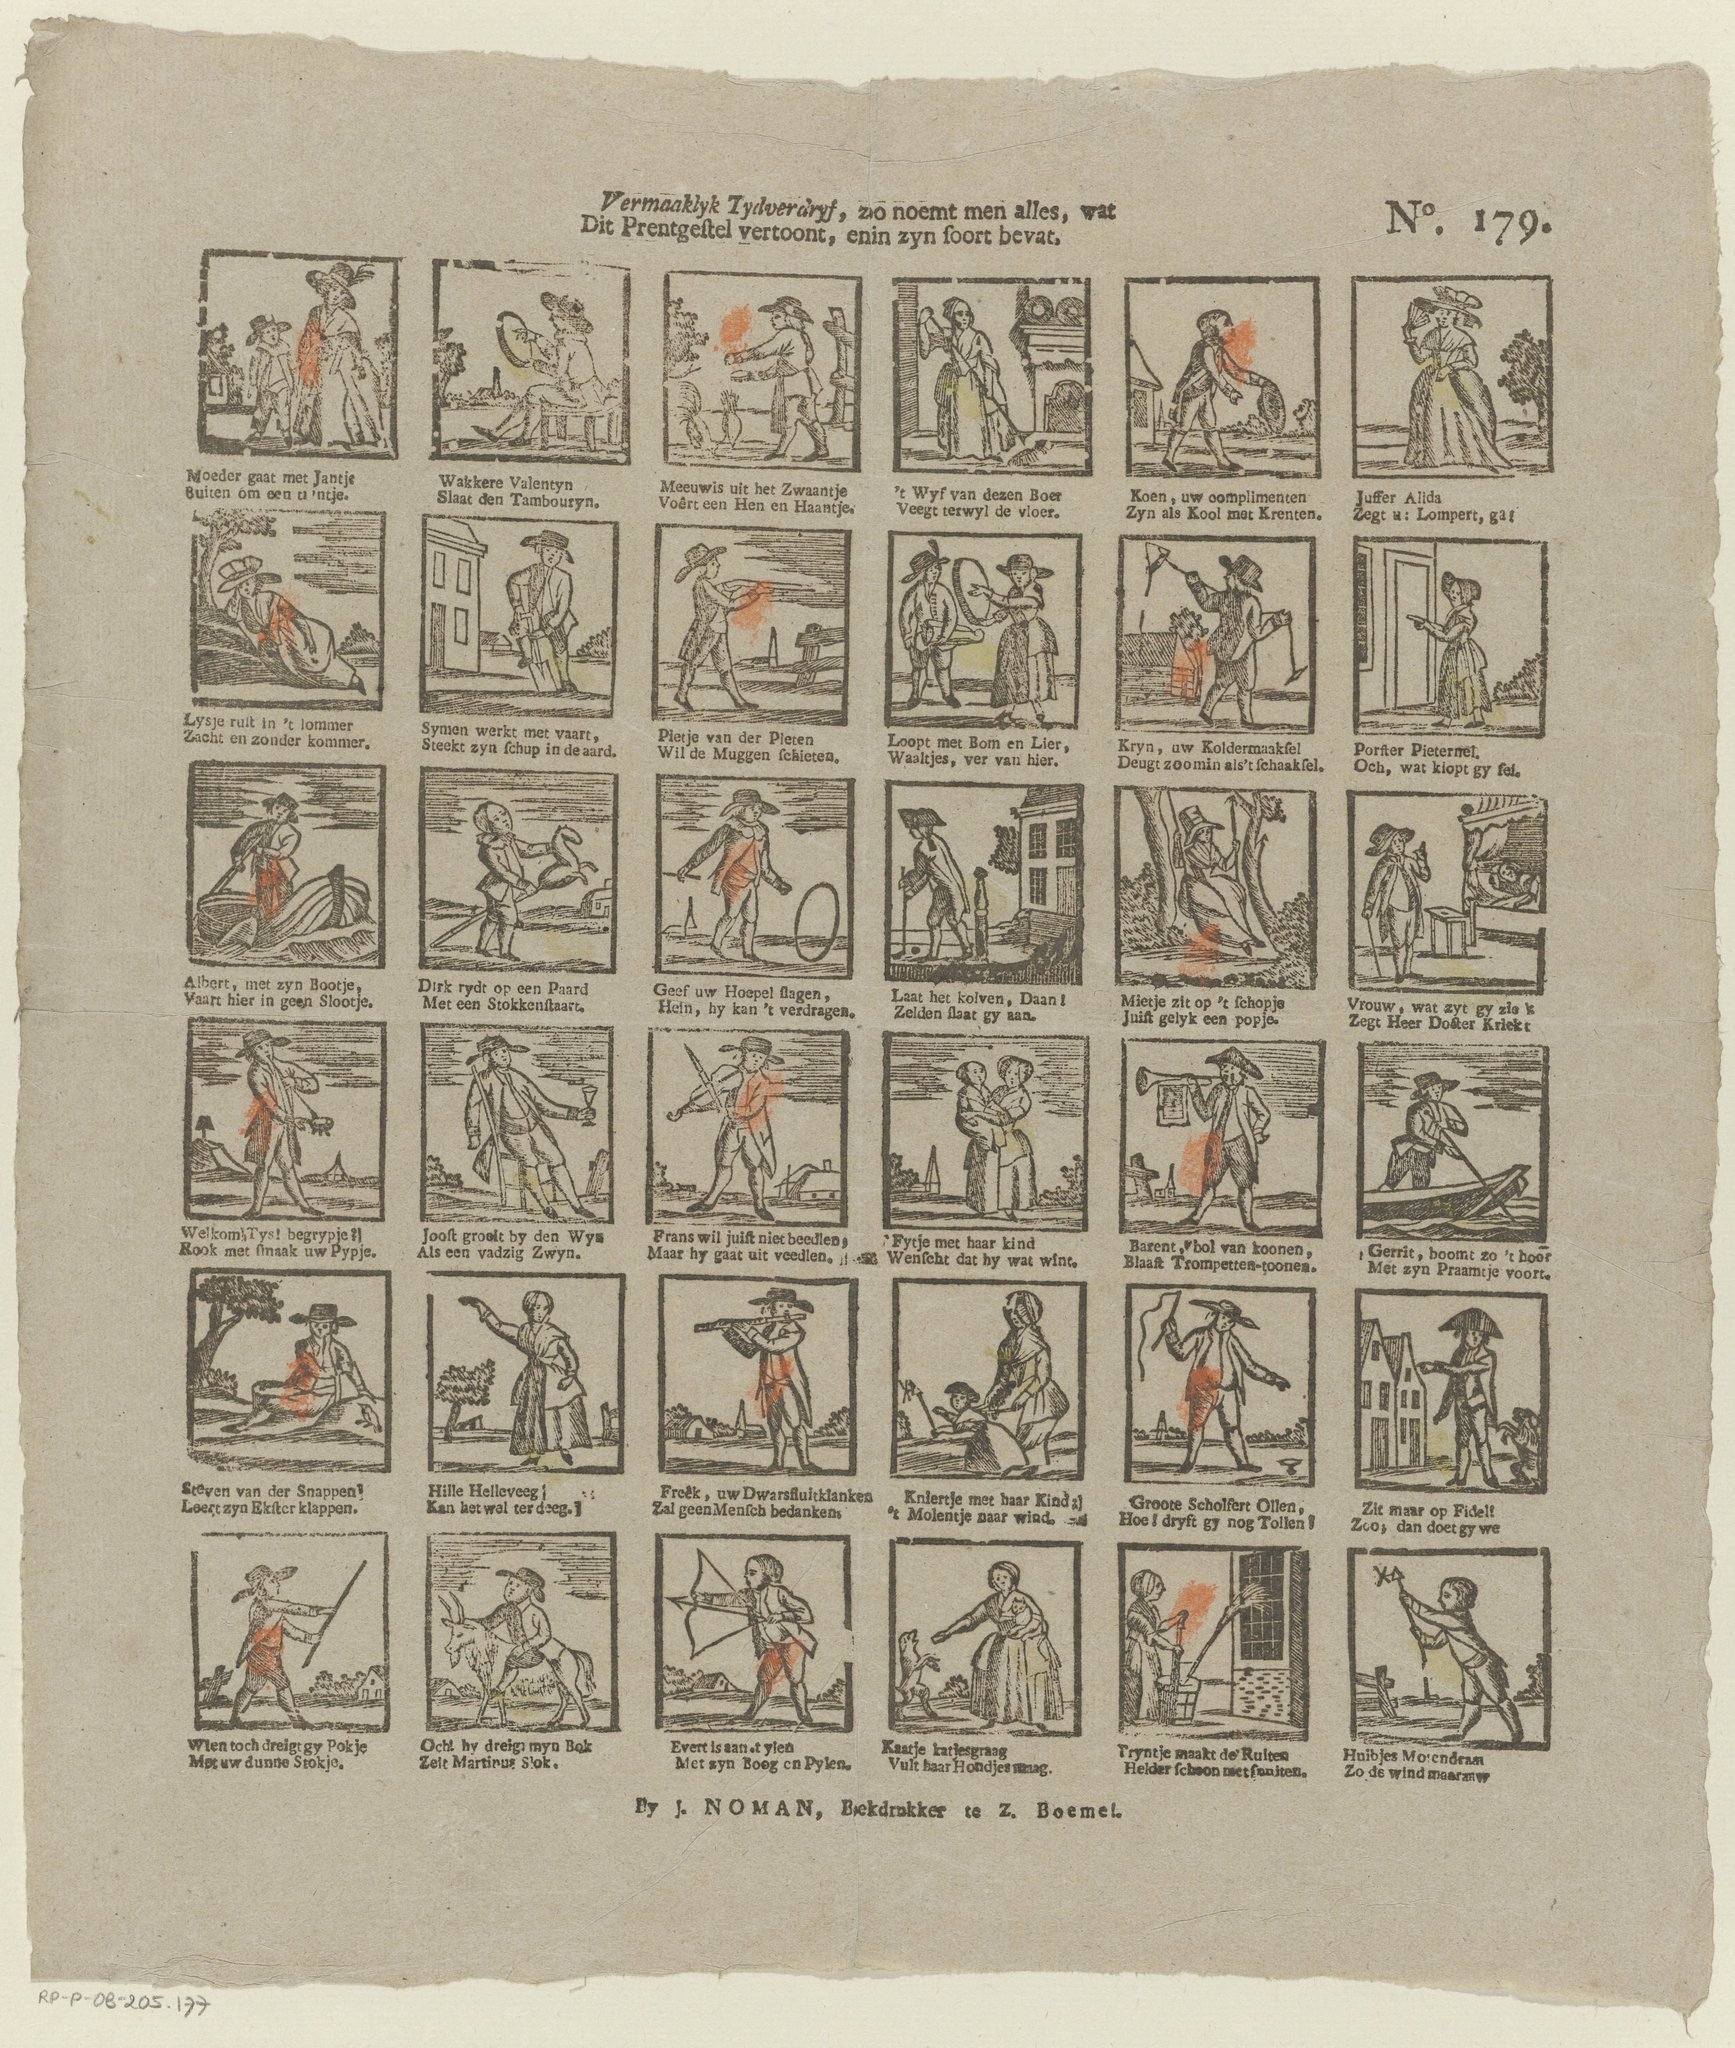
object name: popular print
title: 't Vermaaklyk tydverdryf, zo noemt men alles, wat / Dit prentgestel vertoont, en in zyn soort bevat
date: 1806-1830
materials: paper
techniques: colour, letterpress printing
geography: netherlands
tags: children's games and plays, human types, games using special objects (marbles, top, hoop, etc.)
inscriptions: collector's mark: Lugt 2760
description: Blad met 36 voorstellingen van verschillende figuren, bezigheden en kinderspelen. Onder elke afbeelding een tweeregelig vers. Genummerd rechtsboven: No. 179.